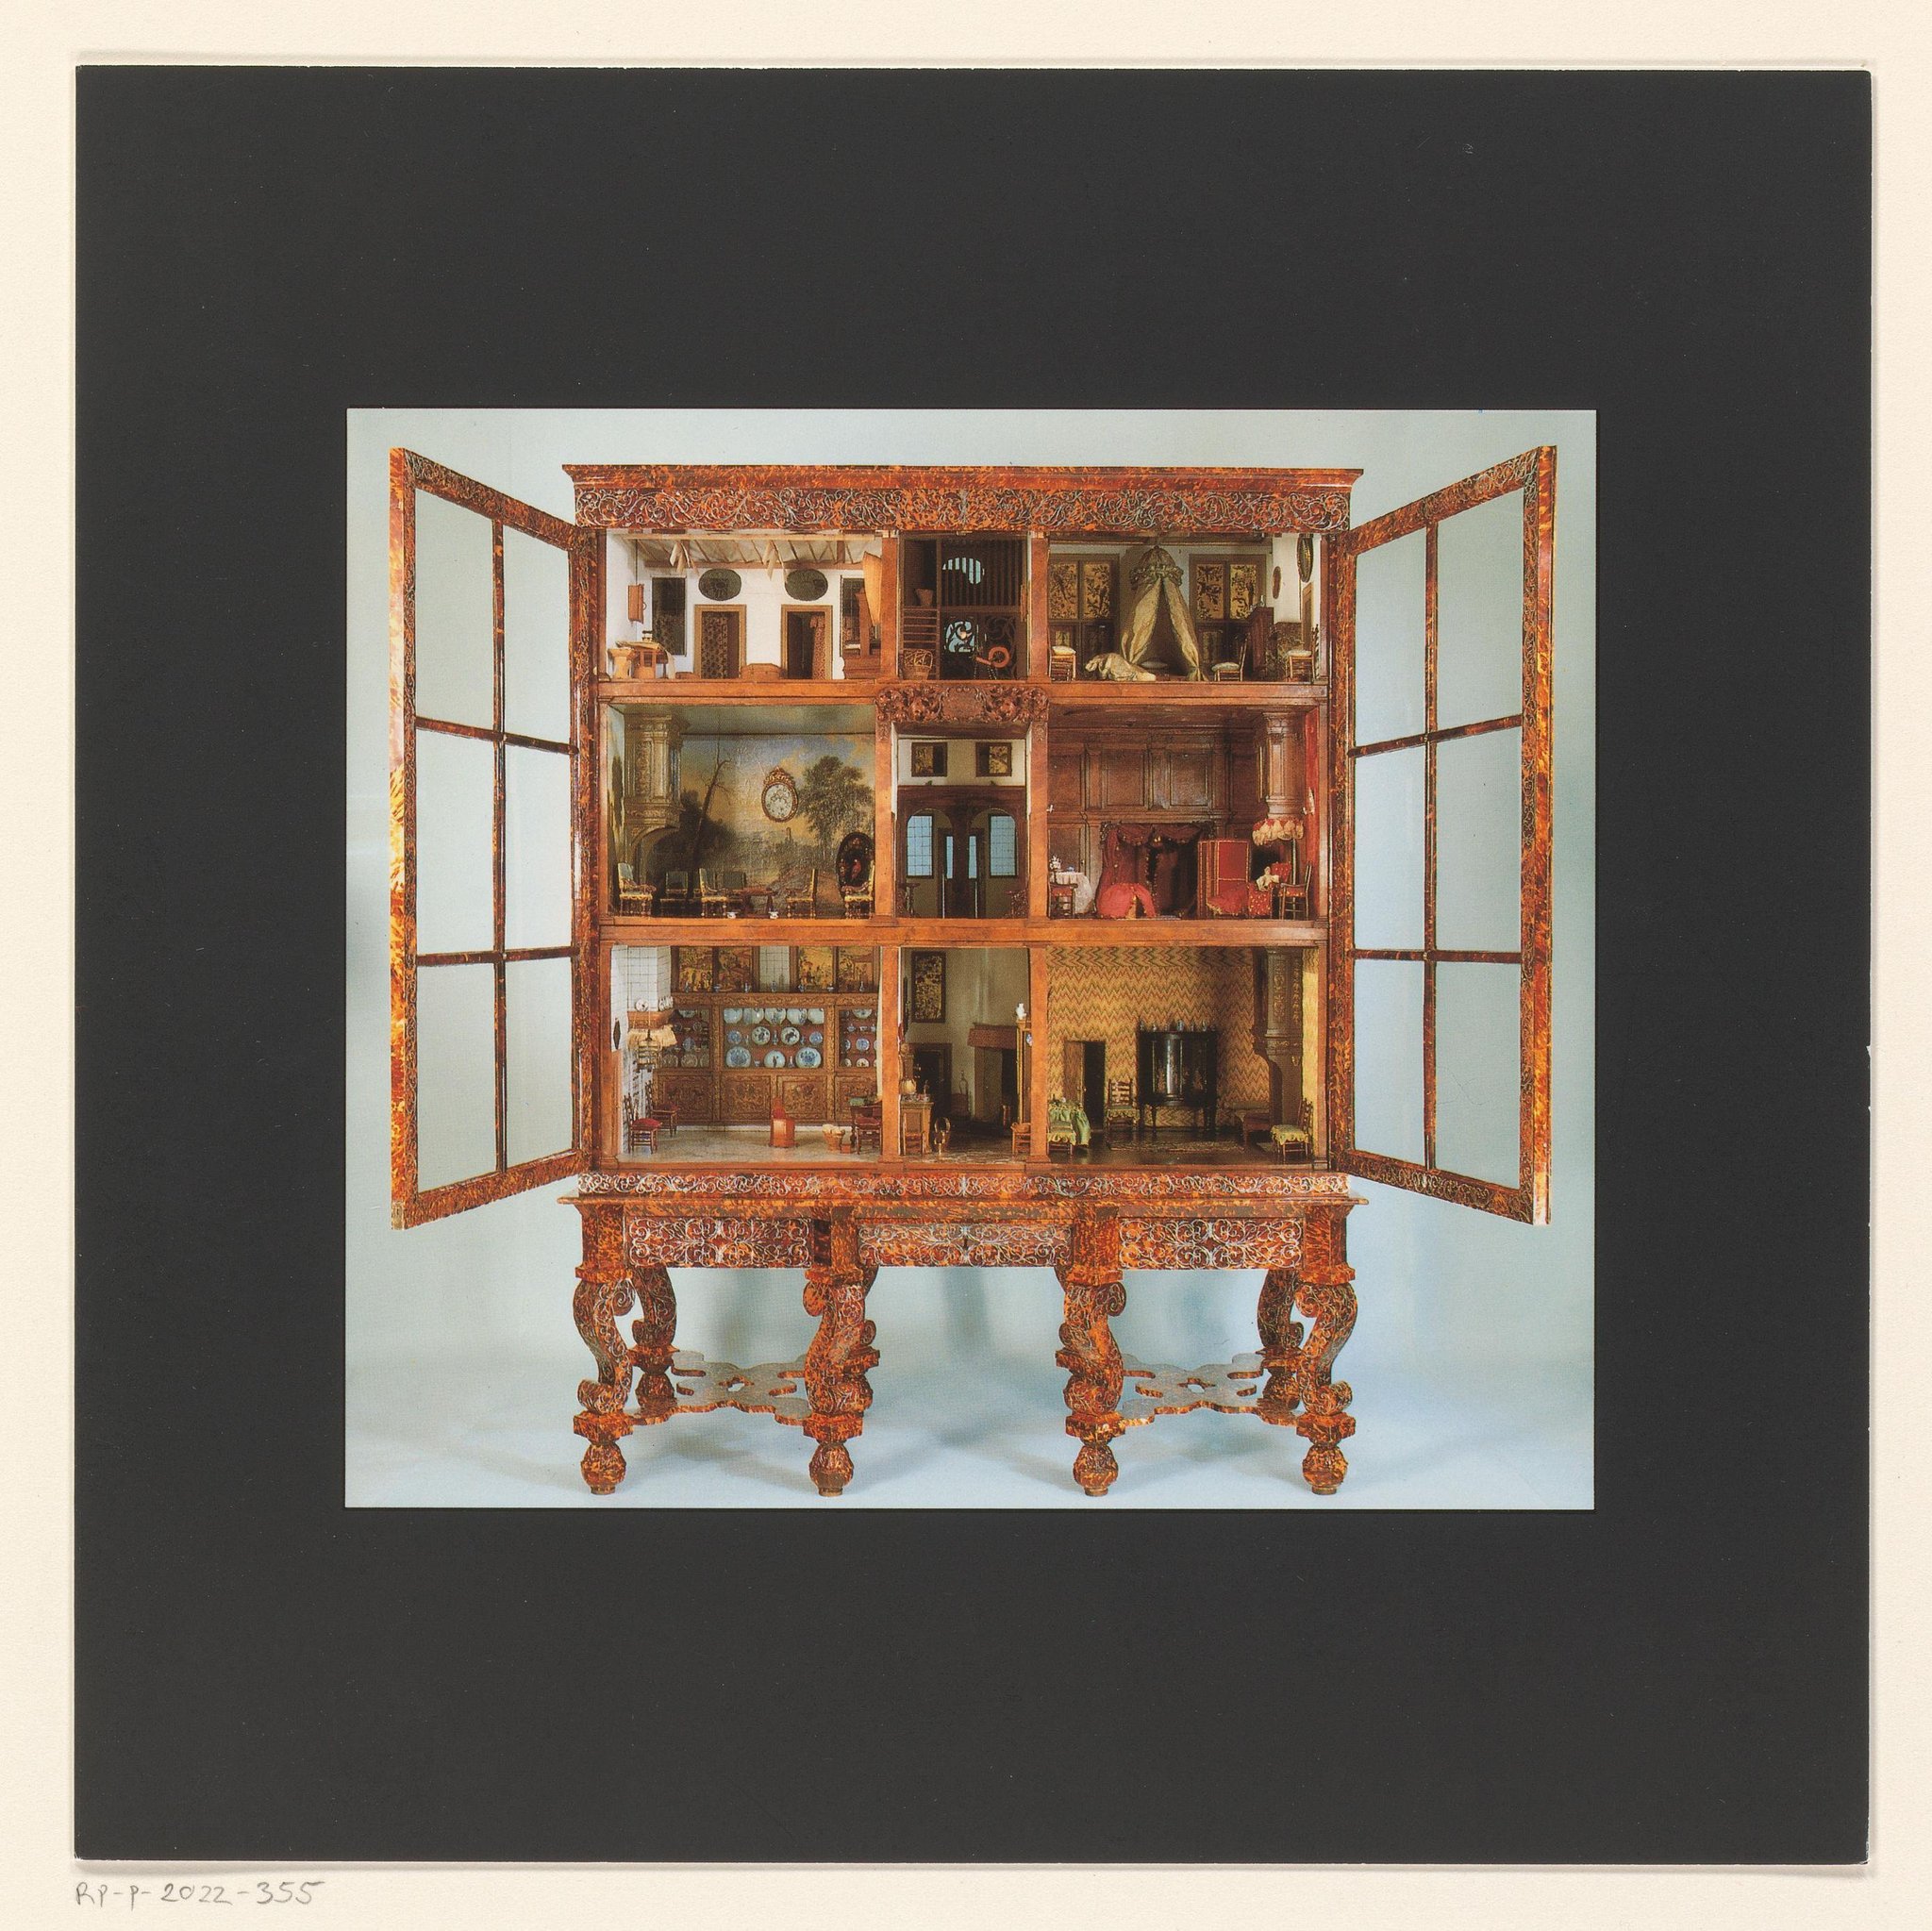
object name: new year card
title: Nieuwjaarskaart voor 1995 van Inmerc bv, Wormer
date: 1994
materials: paper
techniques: offset printed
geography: wormer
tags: january 1 (~ festivities), toy house, doll's house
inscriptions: collector's mark: Lugt 2228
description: Nieuwjaarskaart voor 1995 van Inmerc bv, Wormer. Het poppenhuis van Petronella Oortman.